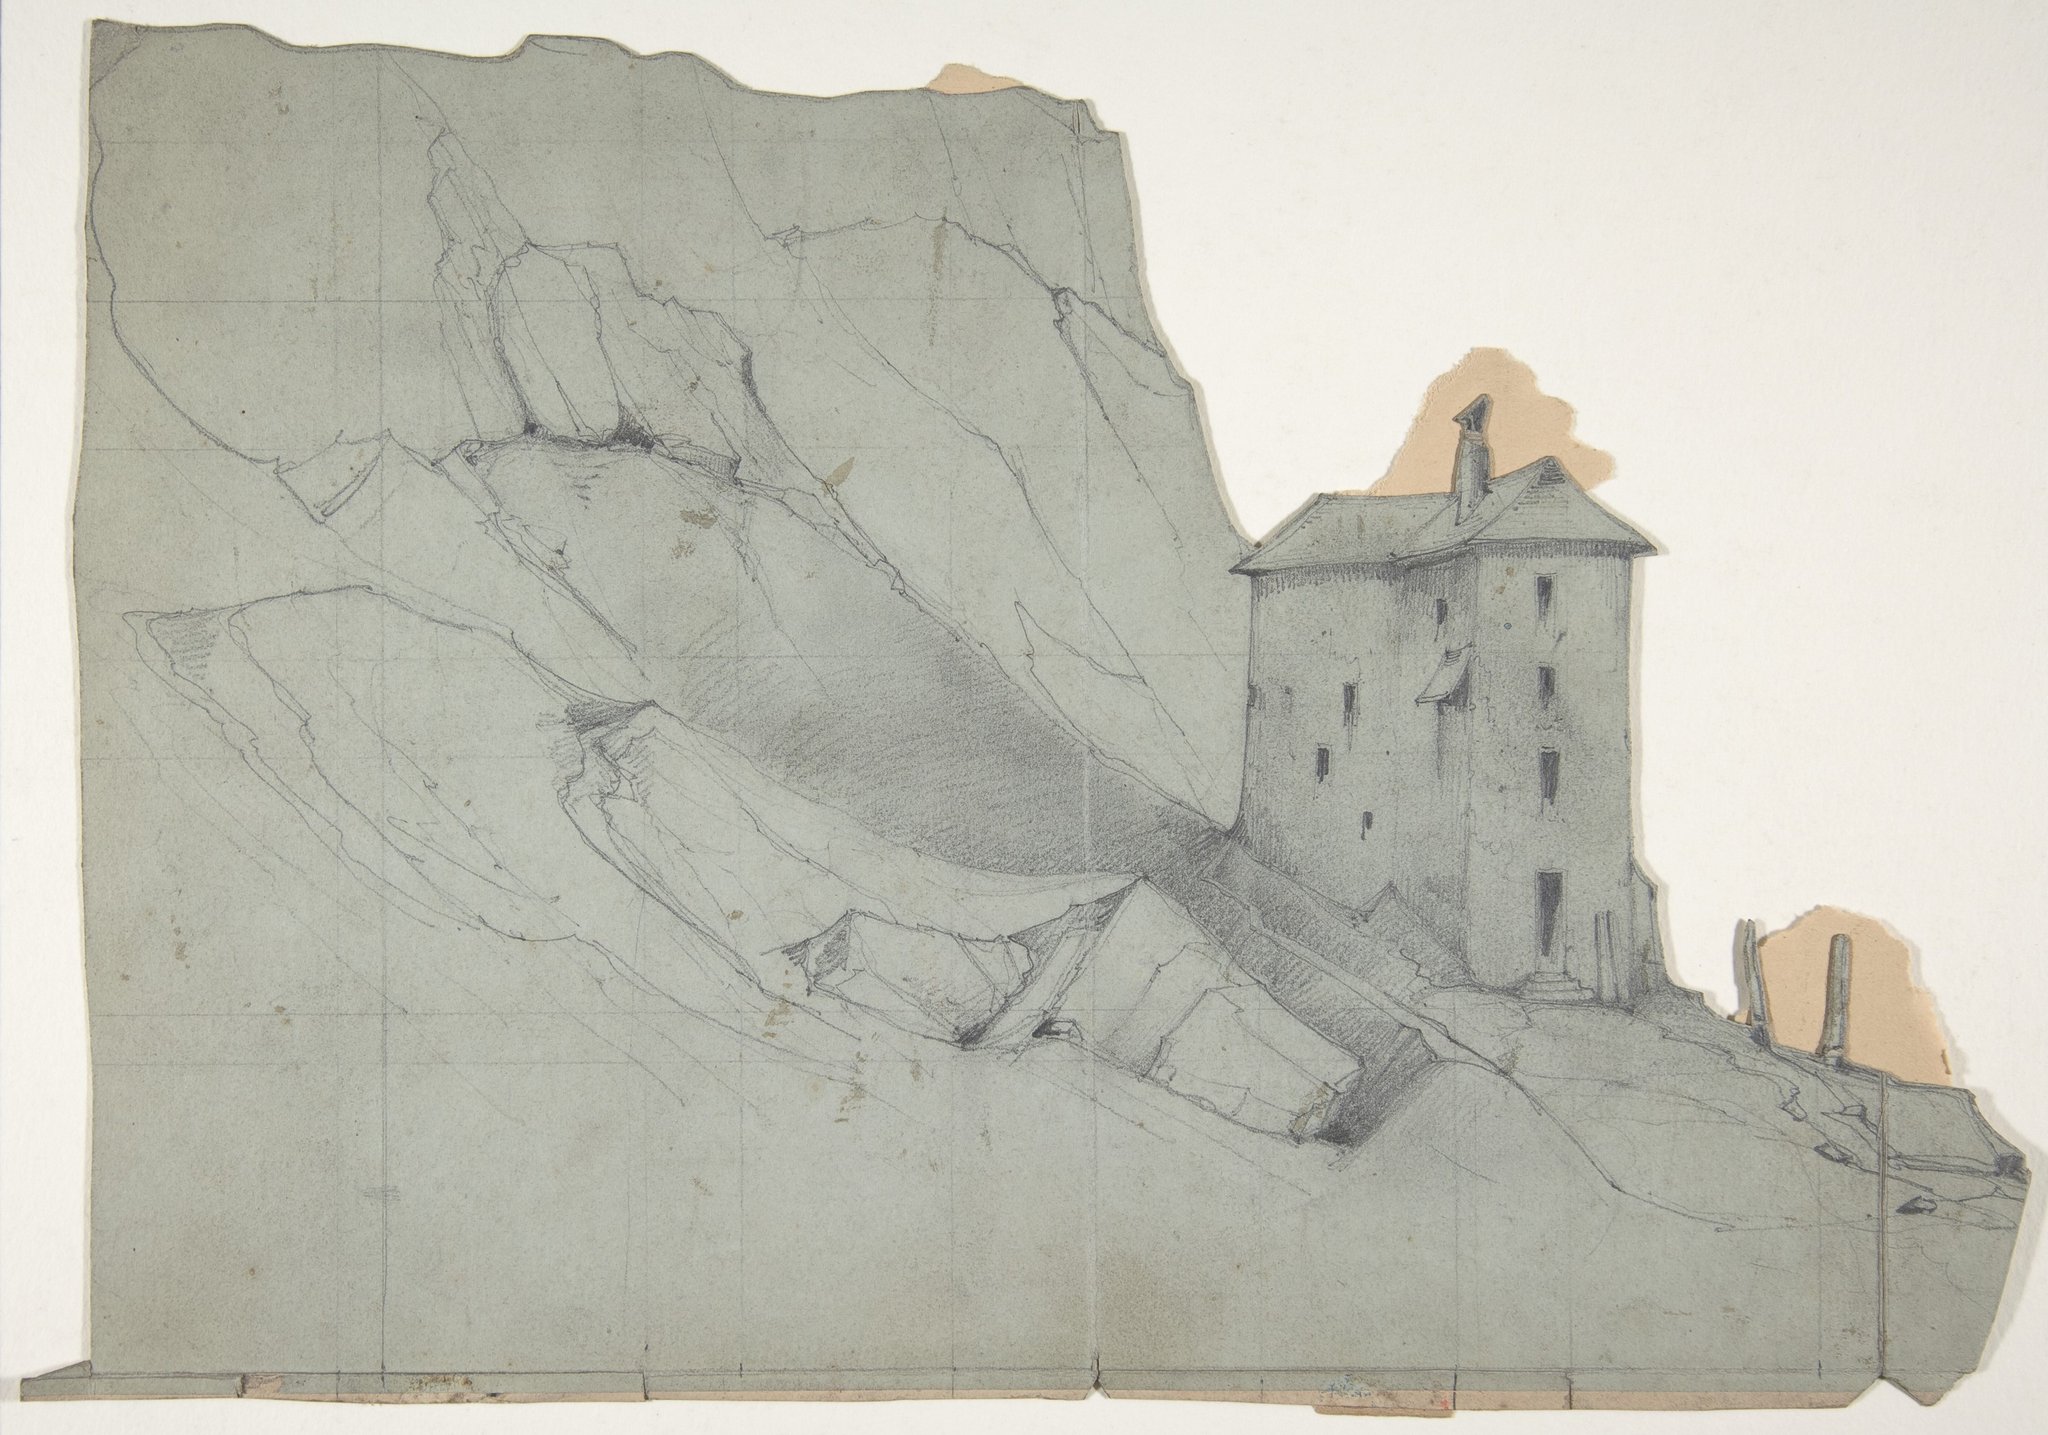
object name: drawing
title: Design for a Stage Set at the Opéra, Paris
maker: eugène cicéri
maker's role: artist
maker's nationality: french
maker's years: 1813-1890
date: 1830-1890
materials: graphite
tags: buildings,stage design